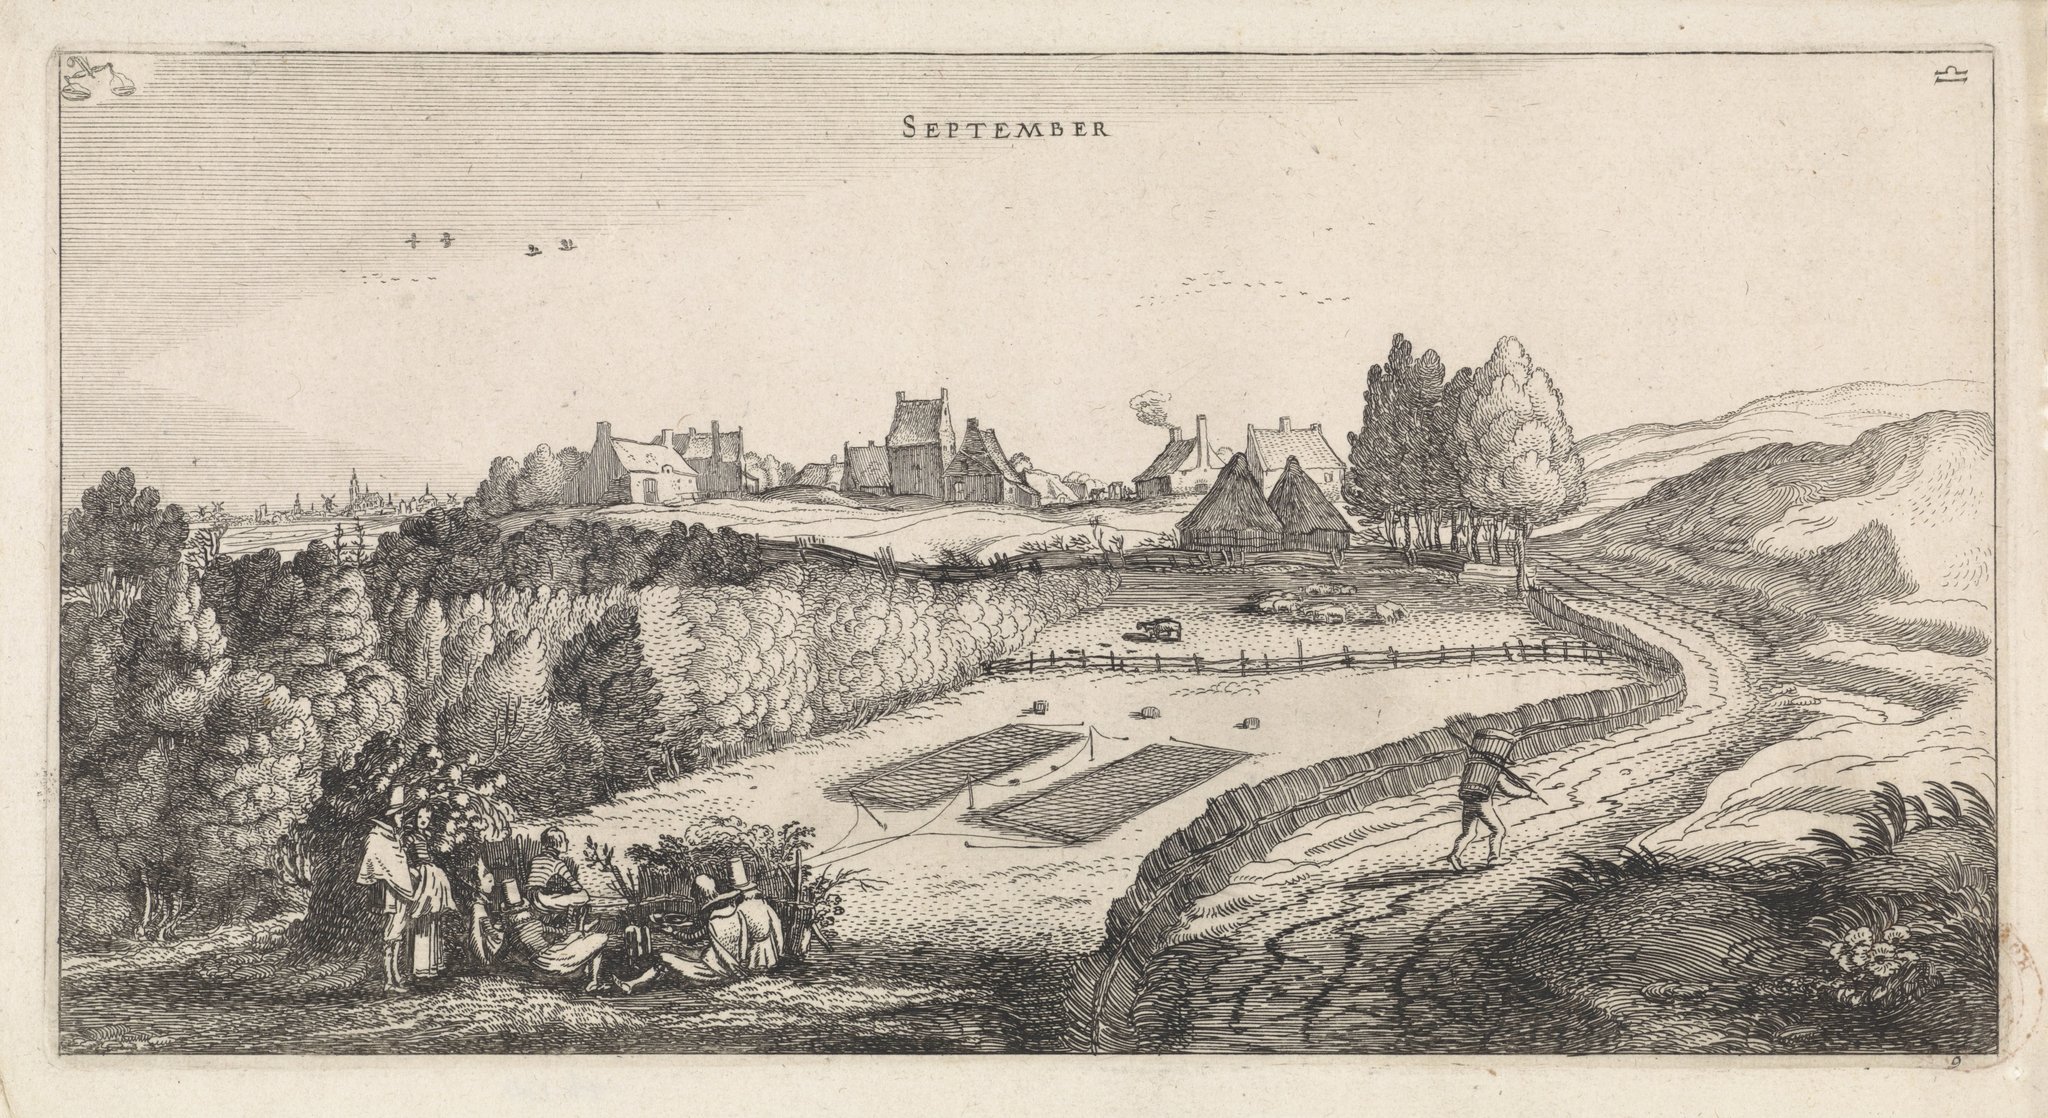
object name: print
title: September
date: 1616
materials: paper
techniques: etching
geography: northern netherlands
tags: prospect of village, silhouette of village, landscape symbolizing september, september and its 'labours', libra (zodiacal sign of september), catching animals, finch trap, finchery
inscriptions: collector's mark: Lugt 240, collector's mark: Lugt 698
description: Een landschap met vogelvangers die achter een bossage hun netten in de gaten houden, voorstellende de maand september. Op de achtergrond een dorp en links een man met een mand op zijn rug op een landweg. Links- en rechtsboven de bij deze maand behorende symbolen van het sterrenbeeld weegschaal. Negende prent uit een serie van twaalf.